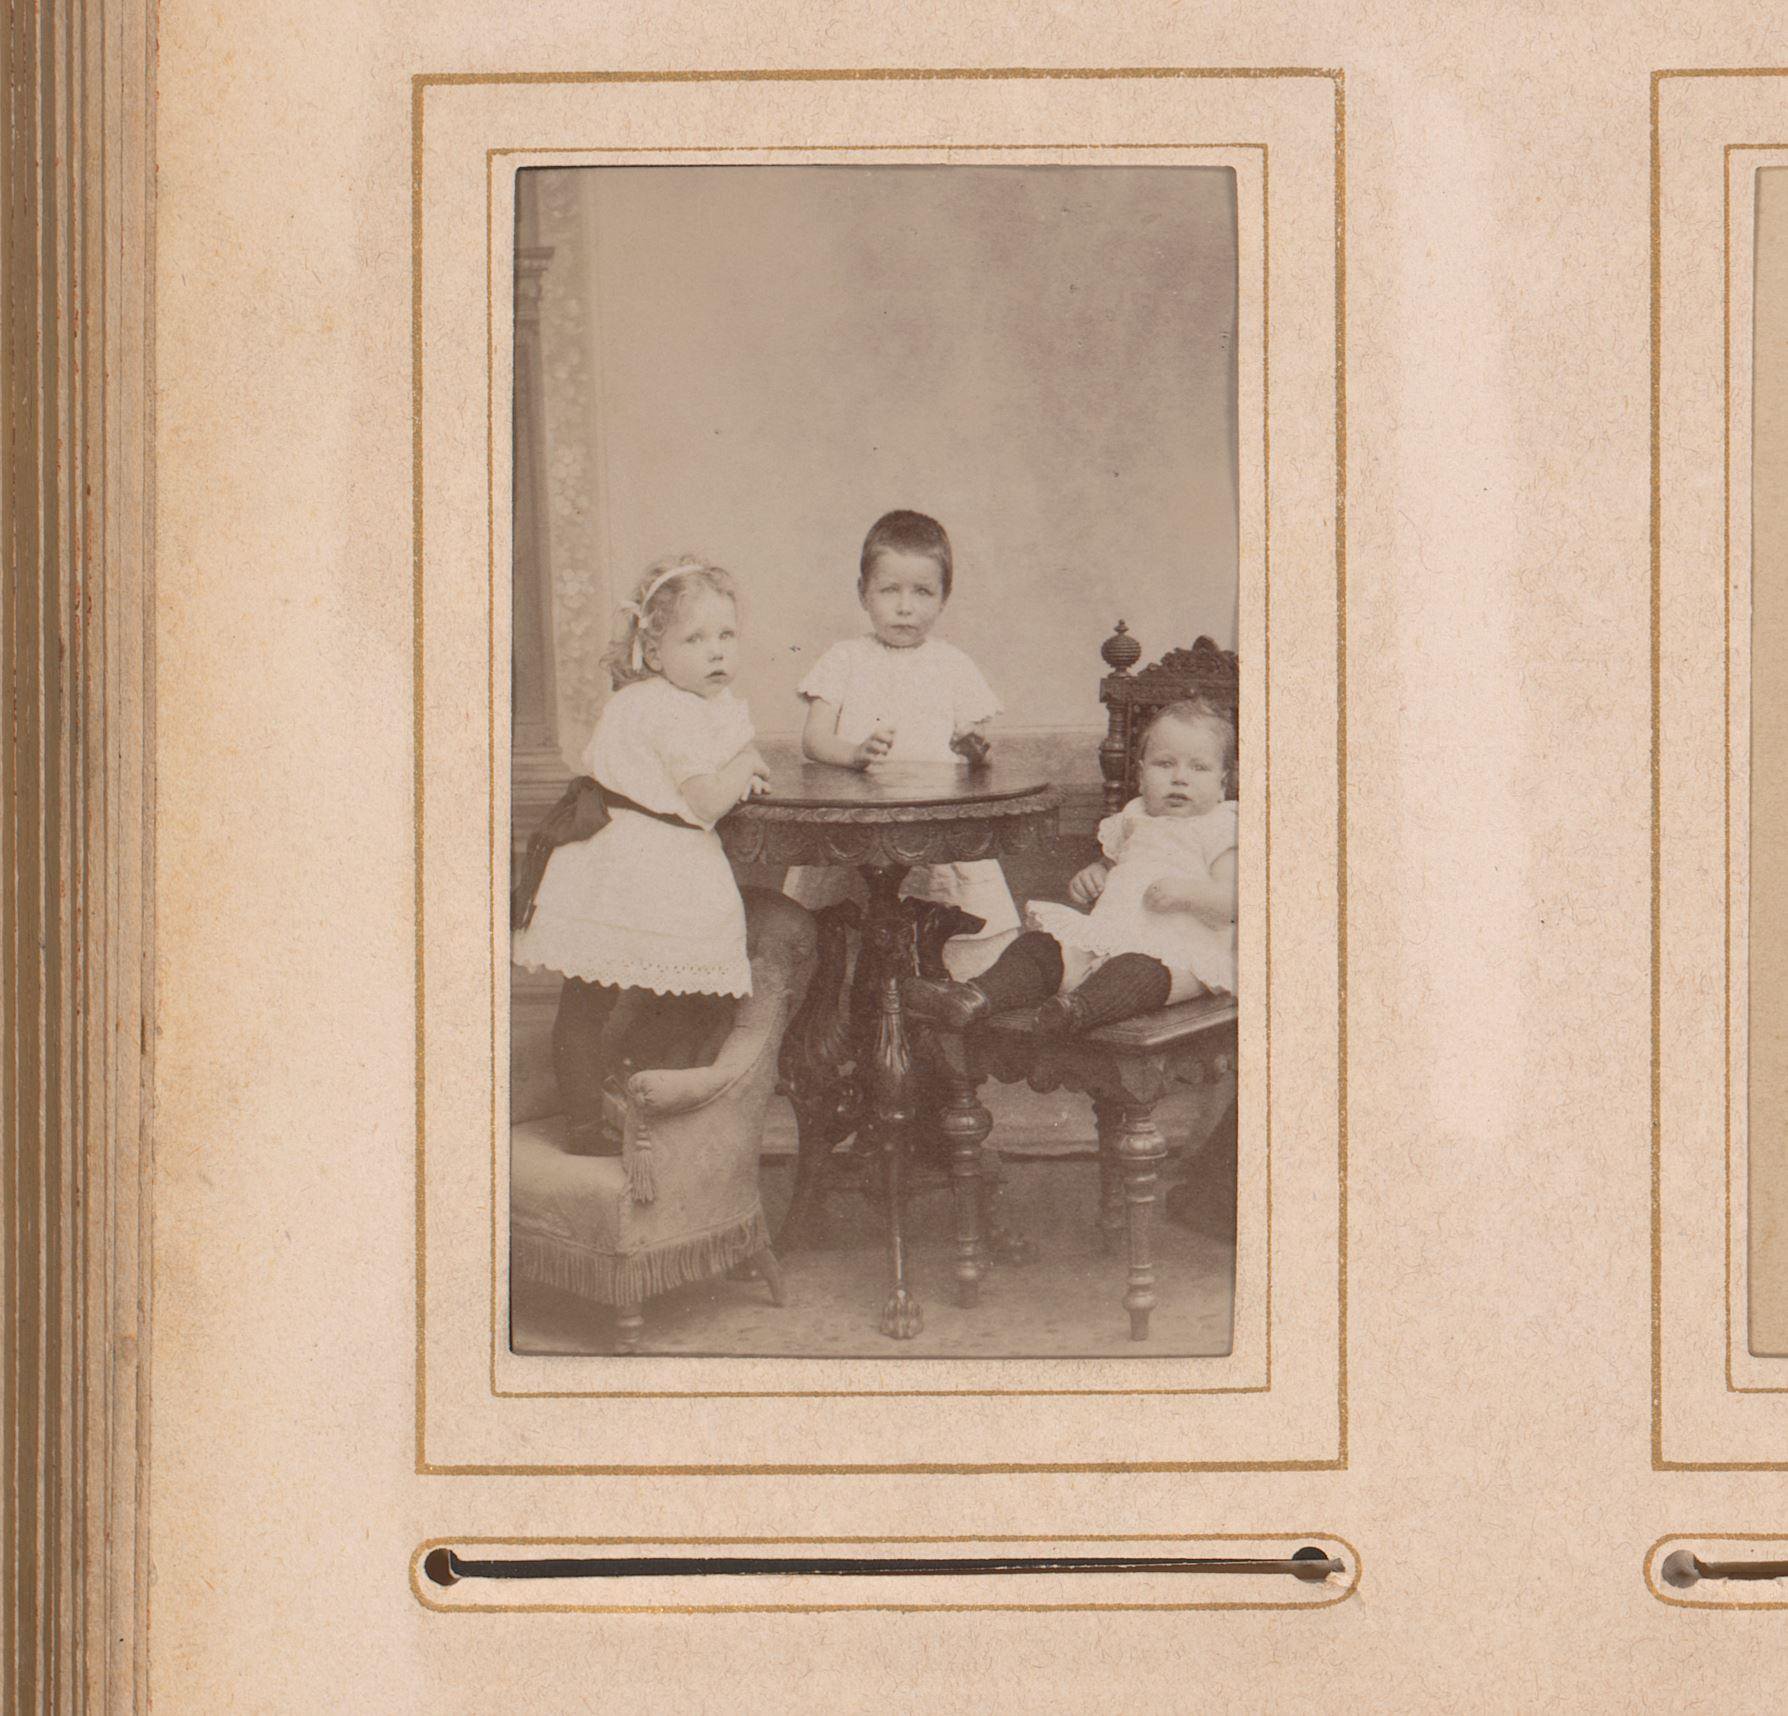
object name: album leaf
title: Groepsportret met drie kinderen, aangeduid als Eva, Koosje en Willem Terlet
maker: johannes leonardus van der heijden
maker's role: fotograaf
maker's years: 1856-1937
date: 1878-1900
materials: cardboard, photographic support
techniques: albumen print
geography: amsterdam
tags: child, anonymous historical persons portrayed in a group, in a group-portrait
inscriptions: annotation: ‘Eva/ Koosje/ Willem/ Terlet’, inscription: ‘Johs. L. v.d. Heyden/ Amsterdam/ Singel 435’